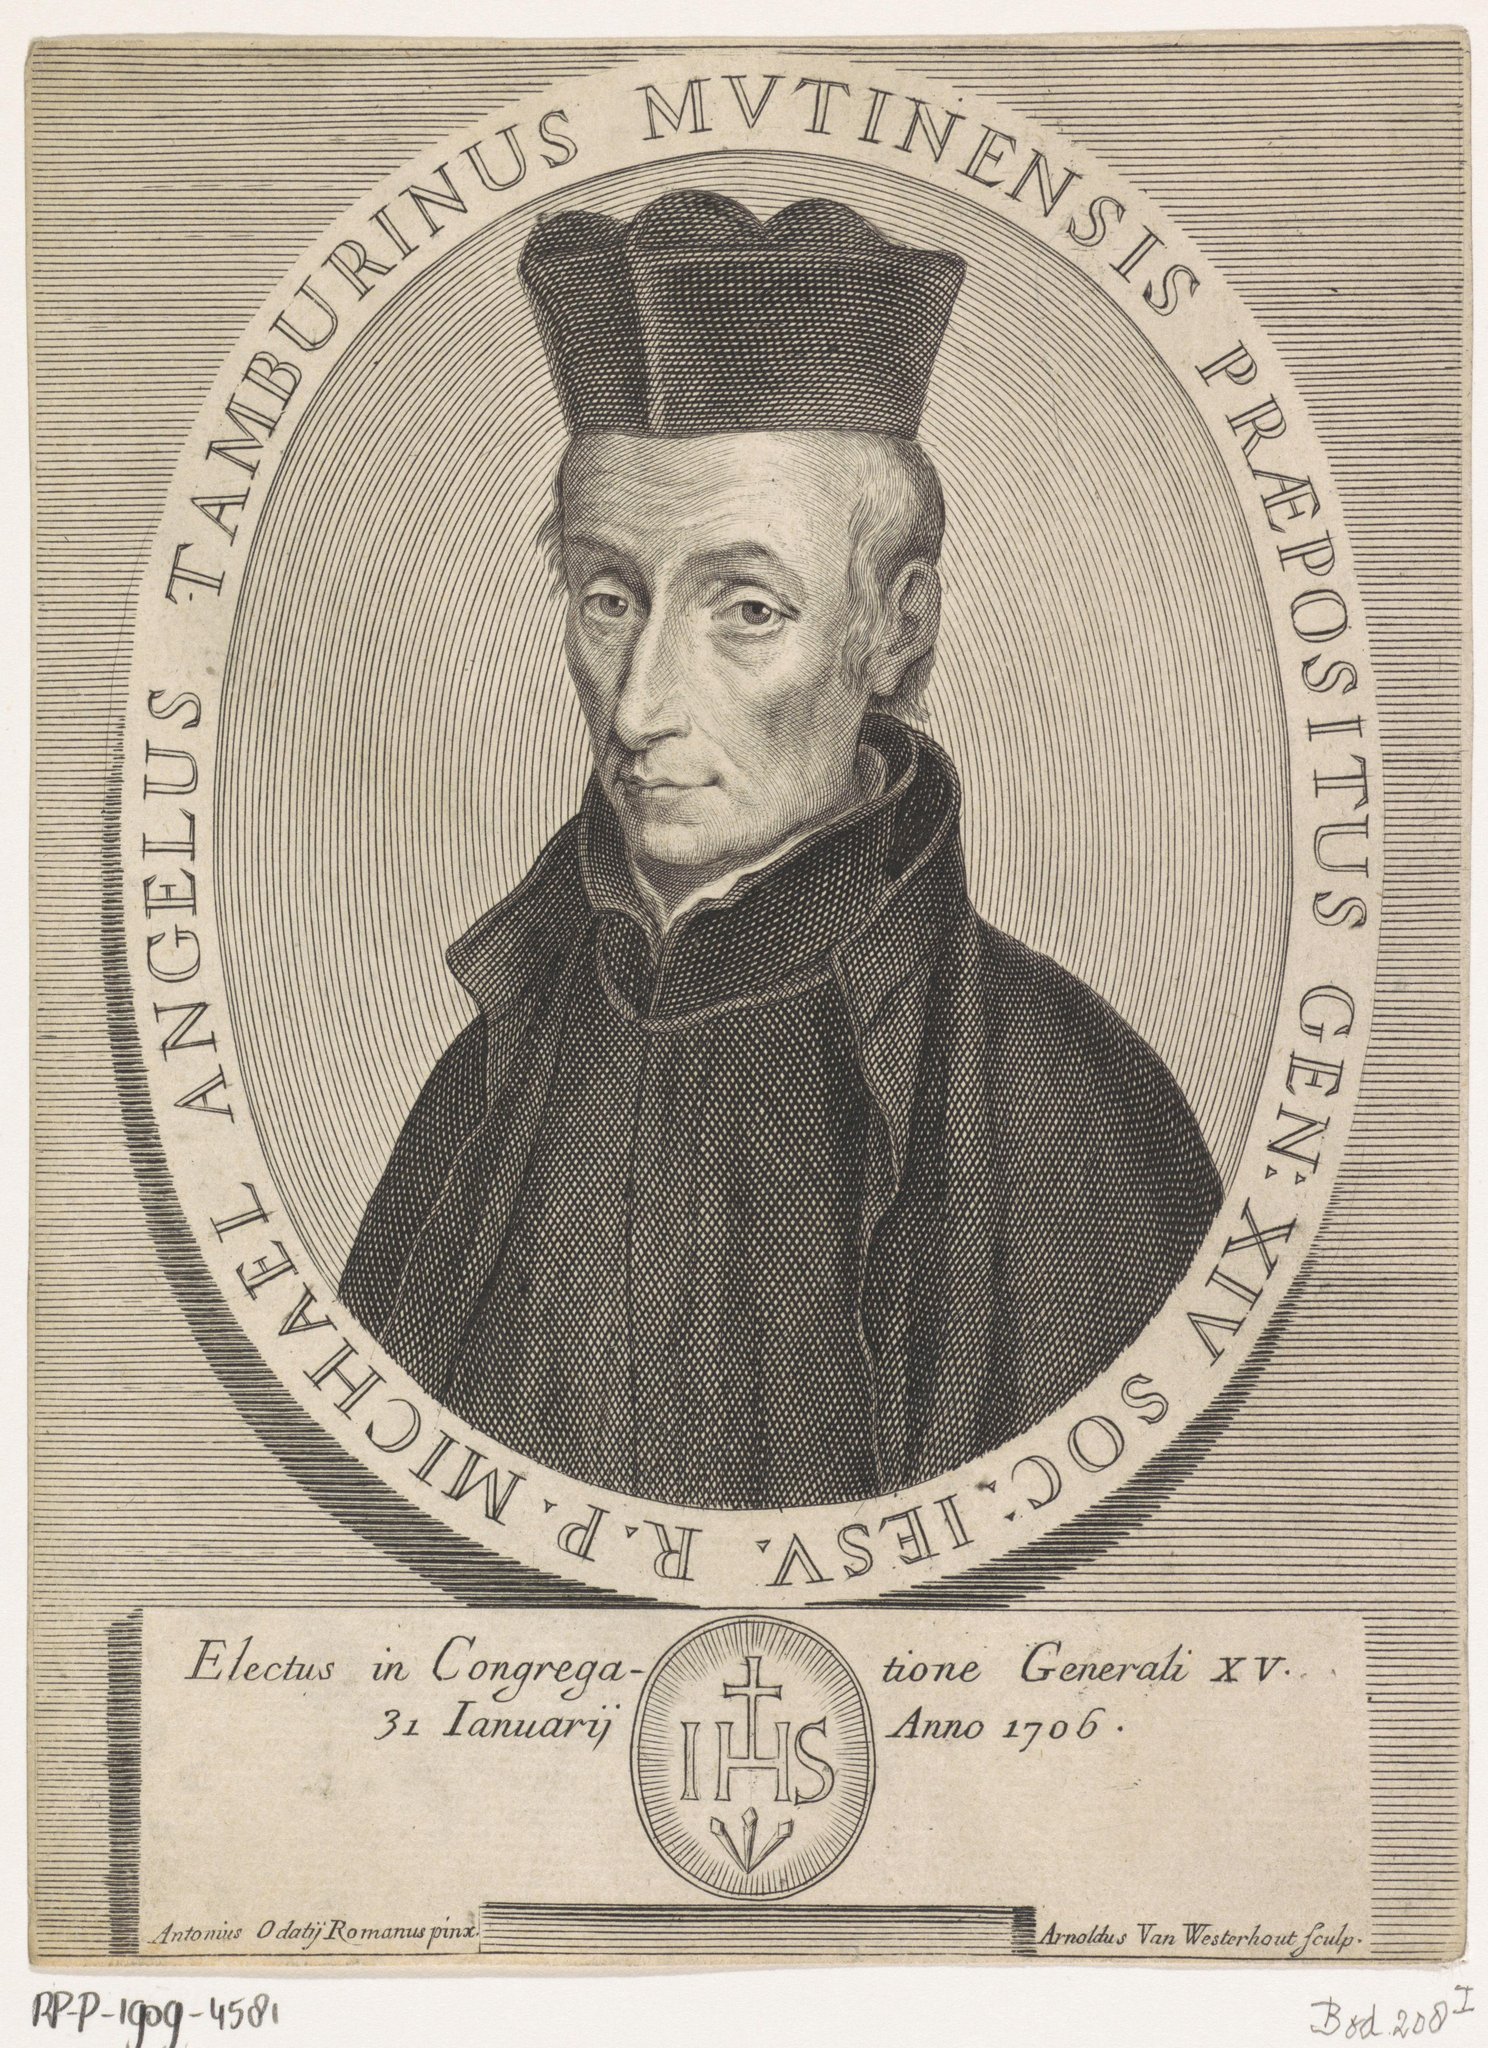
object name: print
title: Portret van de jezuïet Michelangelo Tamburini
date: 1731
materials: paper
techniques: engraving, etching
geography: italy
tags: rome, ihs ('iesus hominum salvator') ~ symbol of christ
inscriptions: collector's mark: Lugt 2228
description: Portret van de jezuïet Michelangelo Tamburini. Hij draagt een biretta. In het kader onder zijn portret het monogram van de jezuïeten.